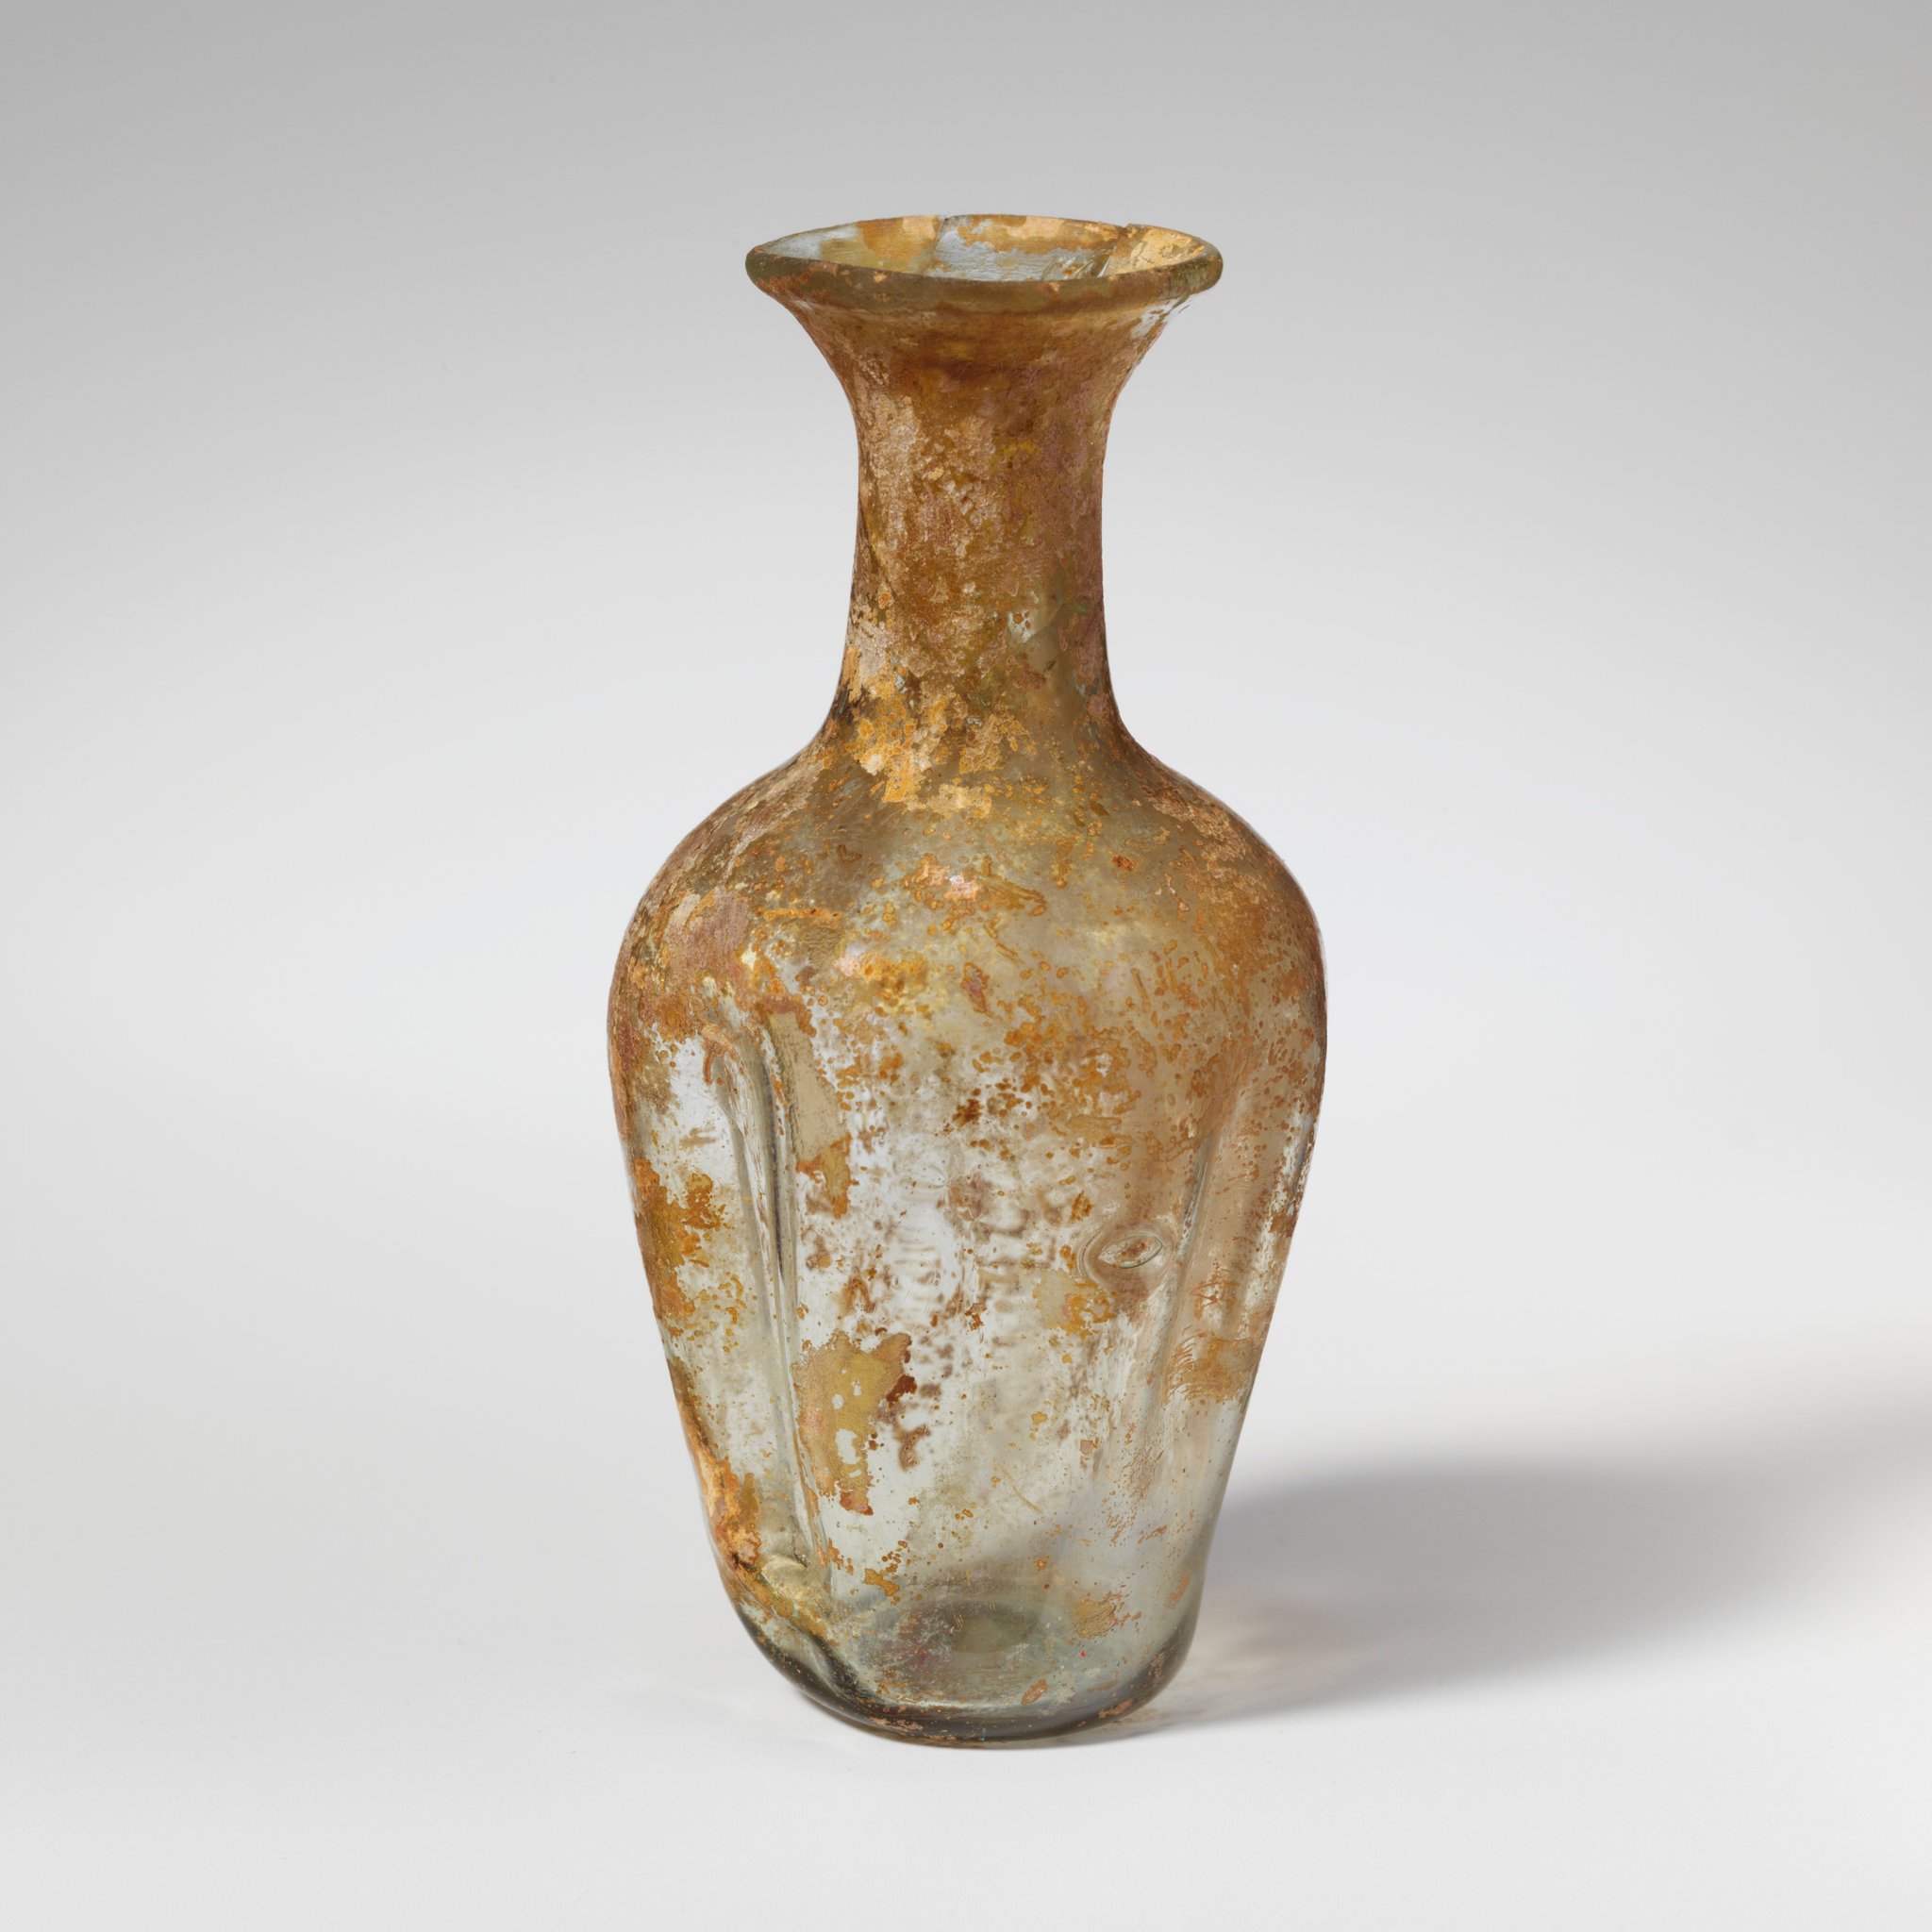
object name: flask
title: Glass flask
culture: roman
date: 101-300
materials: glass